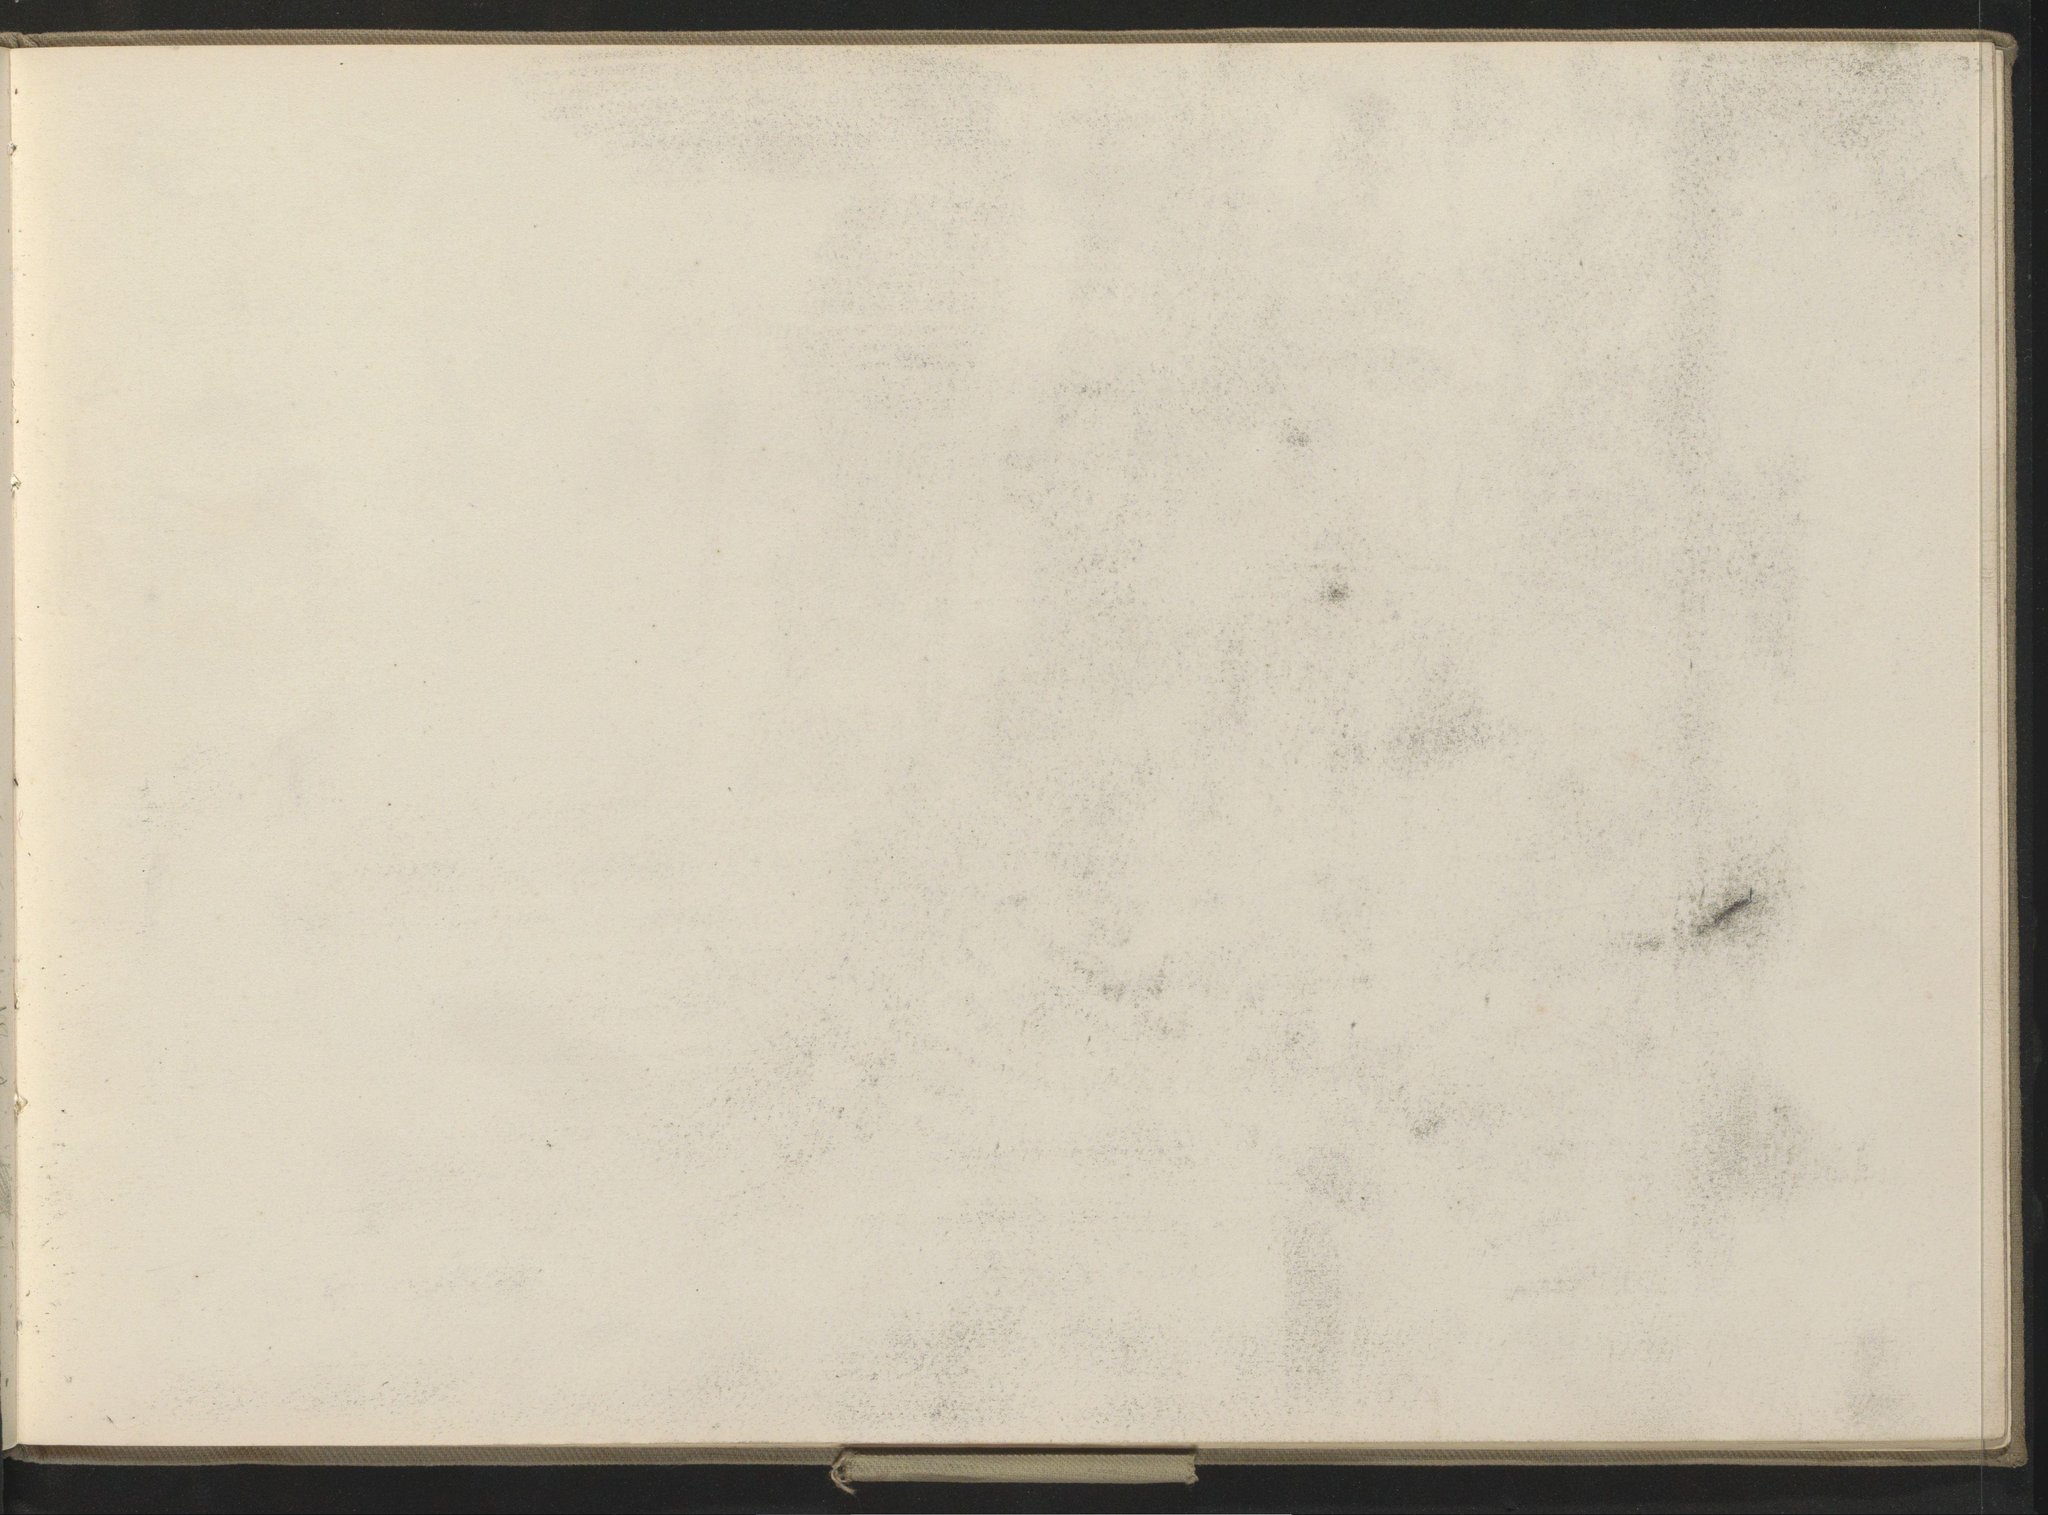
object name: sketchbook leaf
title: Abklatsch van de tekening op pagina 32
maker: willem witsen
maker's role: draughtsman, painter, print maker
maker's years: 1860-1923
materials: paper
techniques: printmaking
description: Pagina 33 uit een schetsboek met 32 bladen.